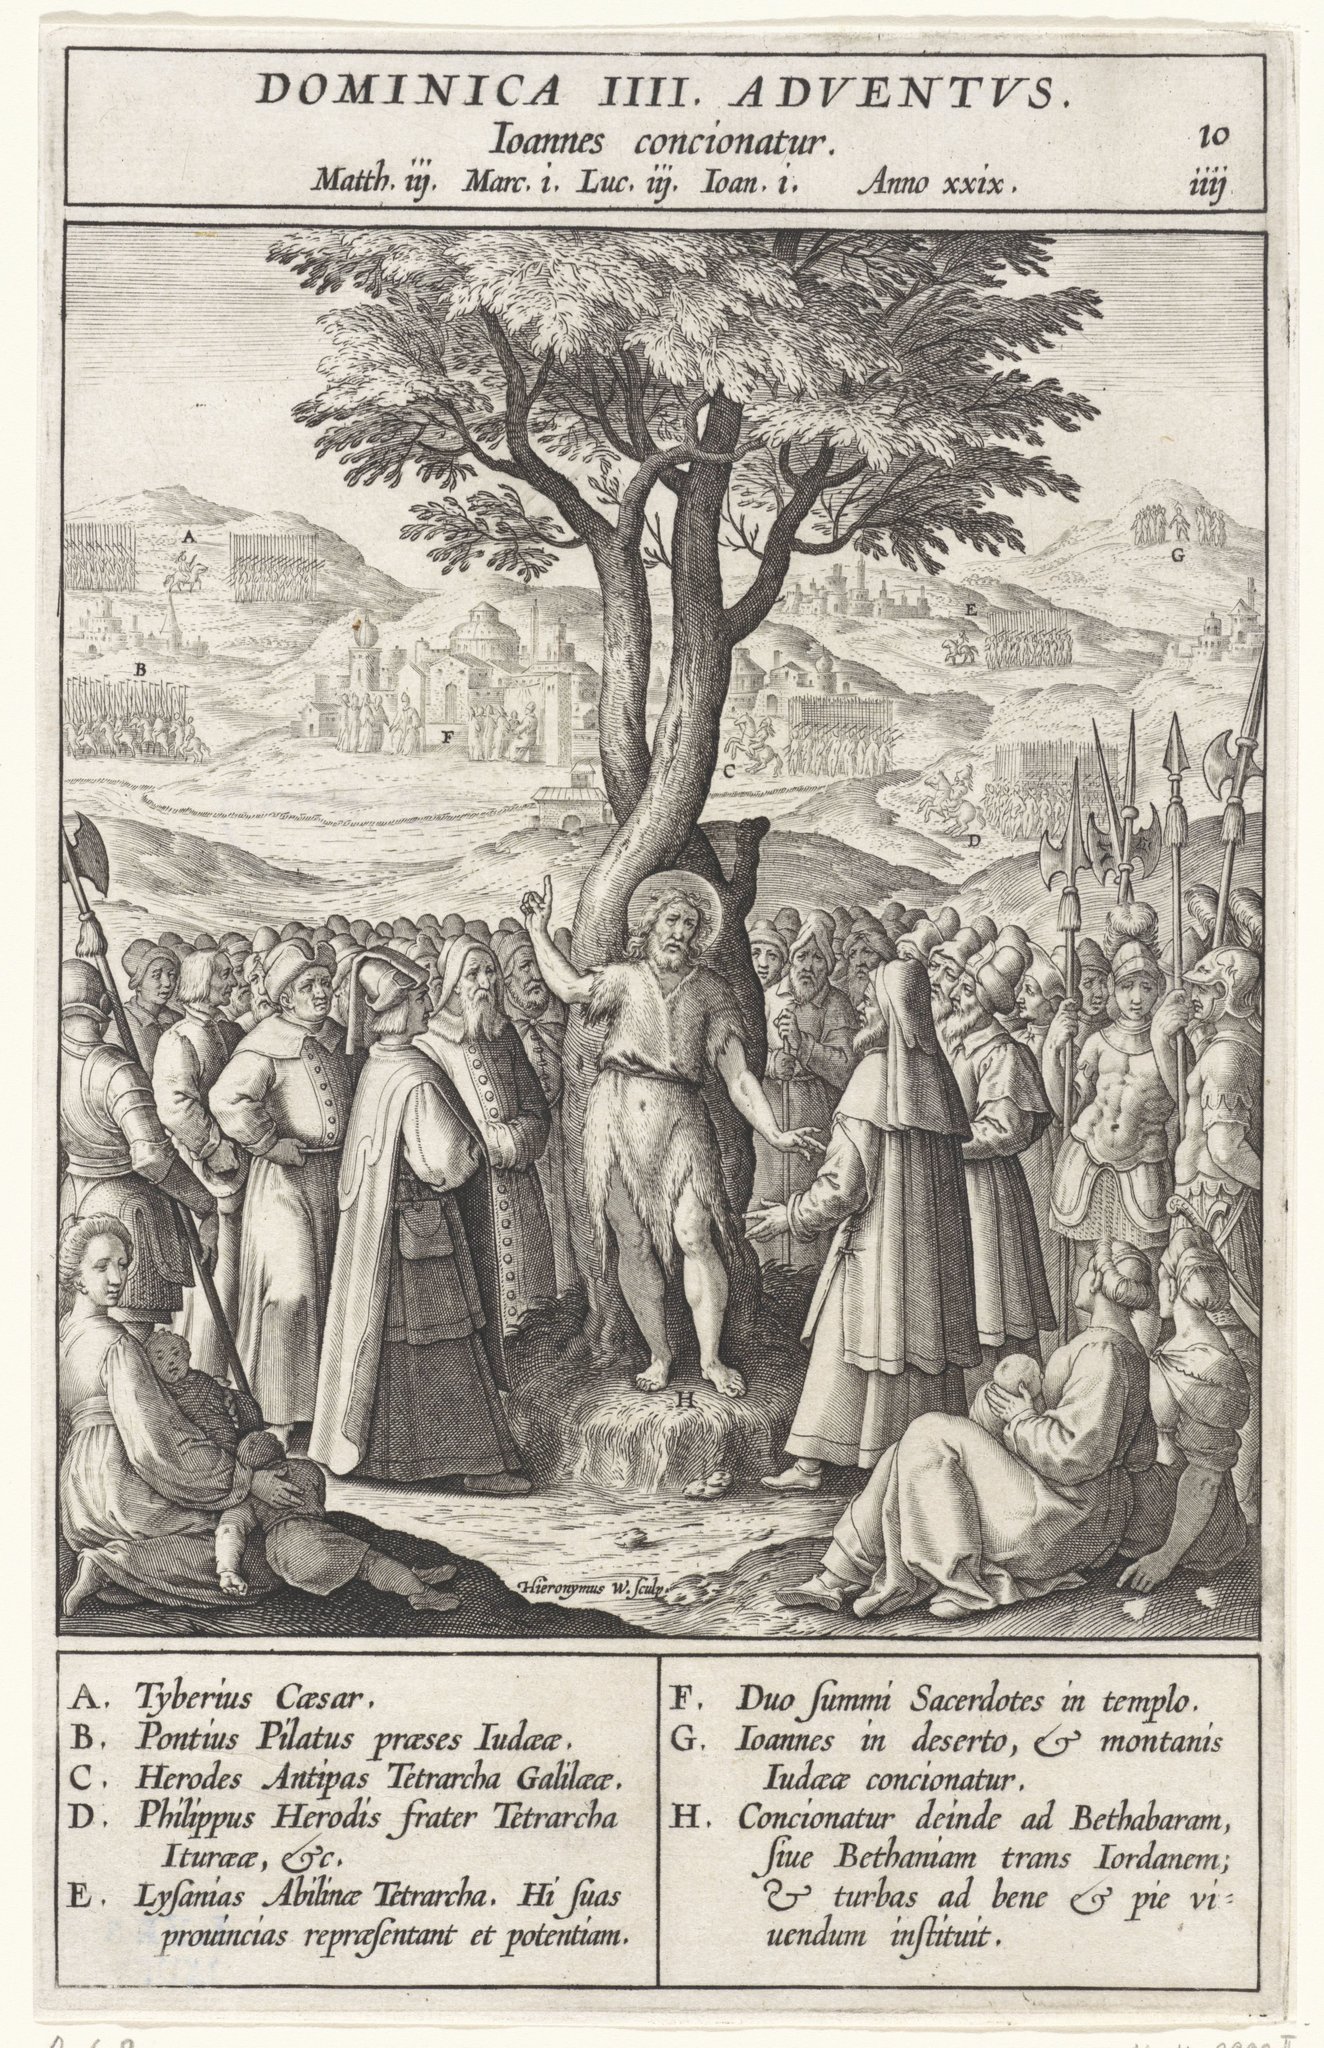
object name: print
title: Dominica IIII. Adventvs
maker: hieronymus wierix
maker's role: draughtsman, print maker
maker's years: 1553-1619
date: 1593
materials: paper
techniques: engraving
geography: antwerp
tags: john preaching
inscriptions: collector's mark: Lugt 2165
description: Johannes de Doper, in kamelenvacht, predikend bij een boom te midden van het volk. Bij verschillende elementen uit de voorstelling staan letters die corresponderen met de legenda in de marge.